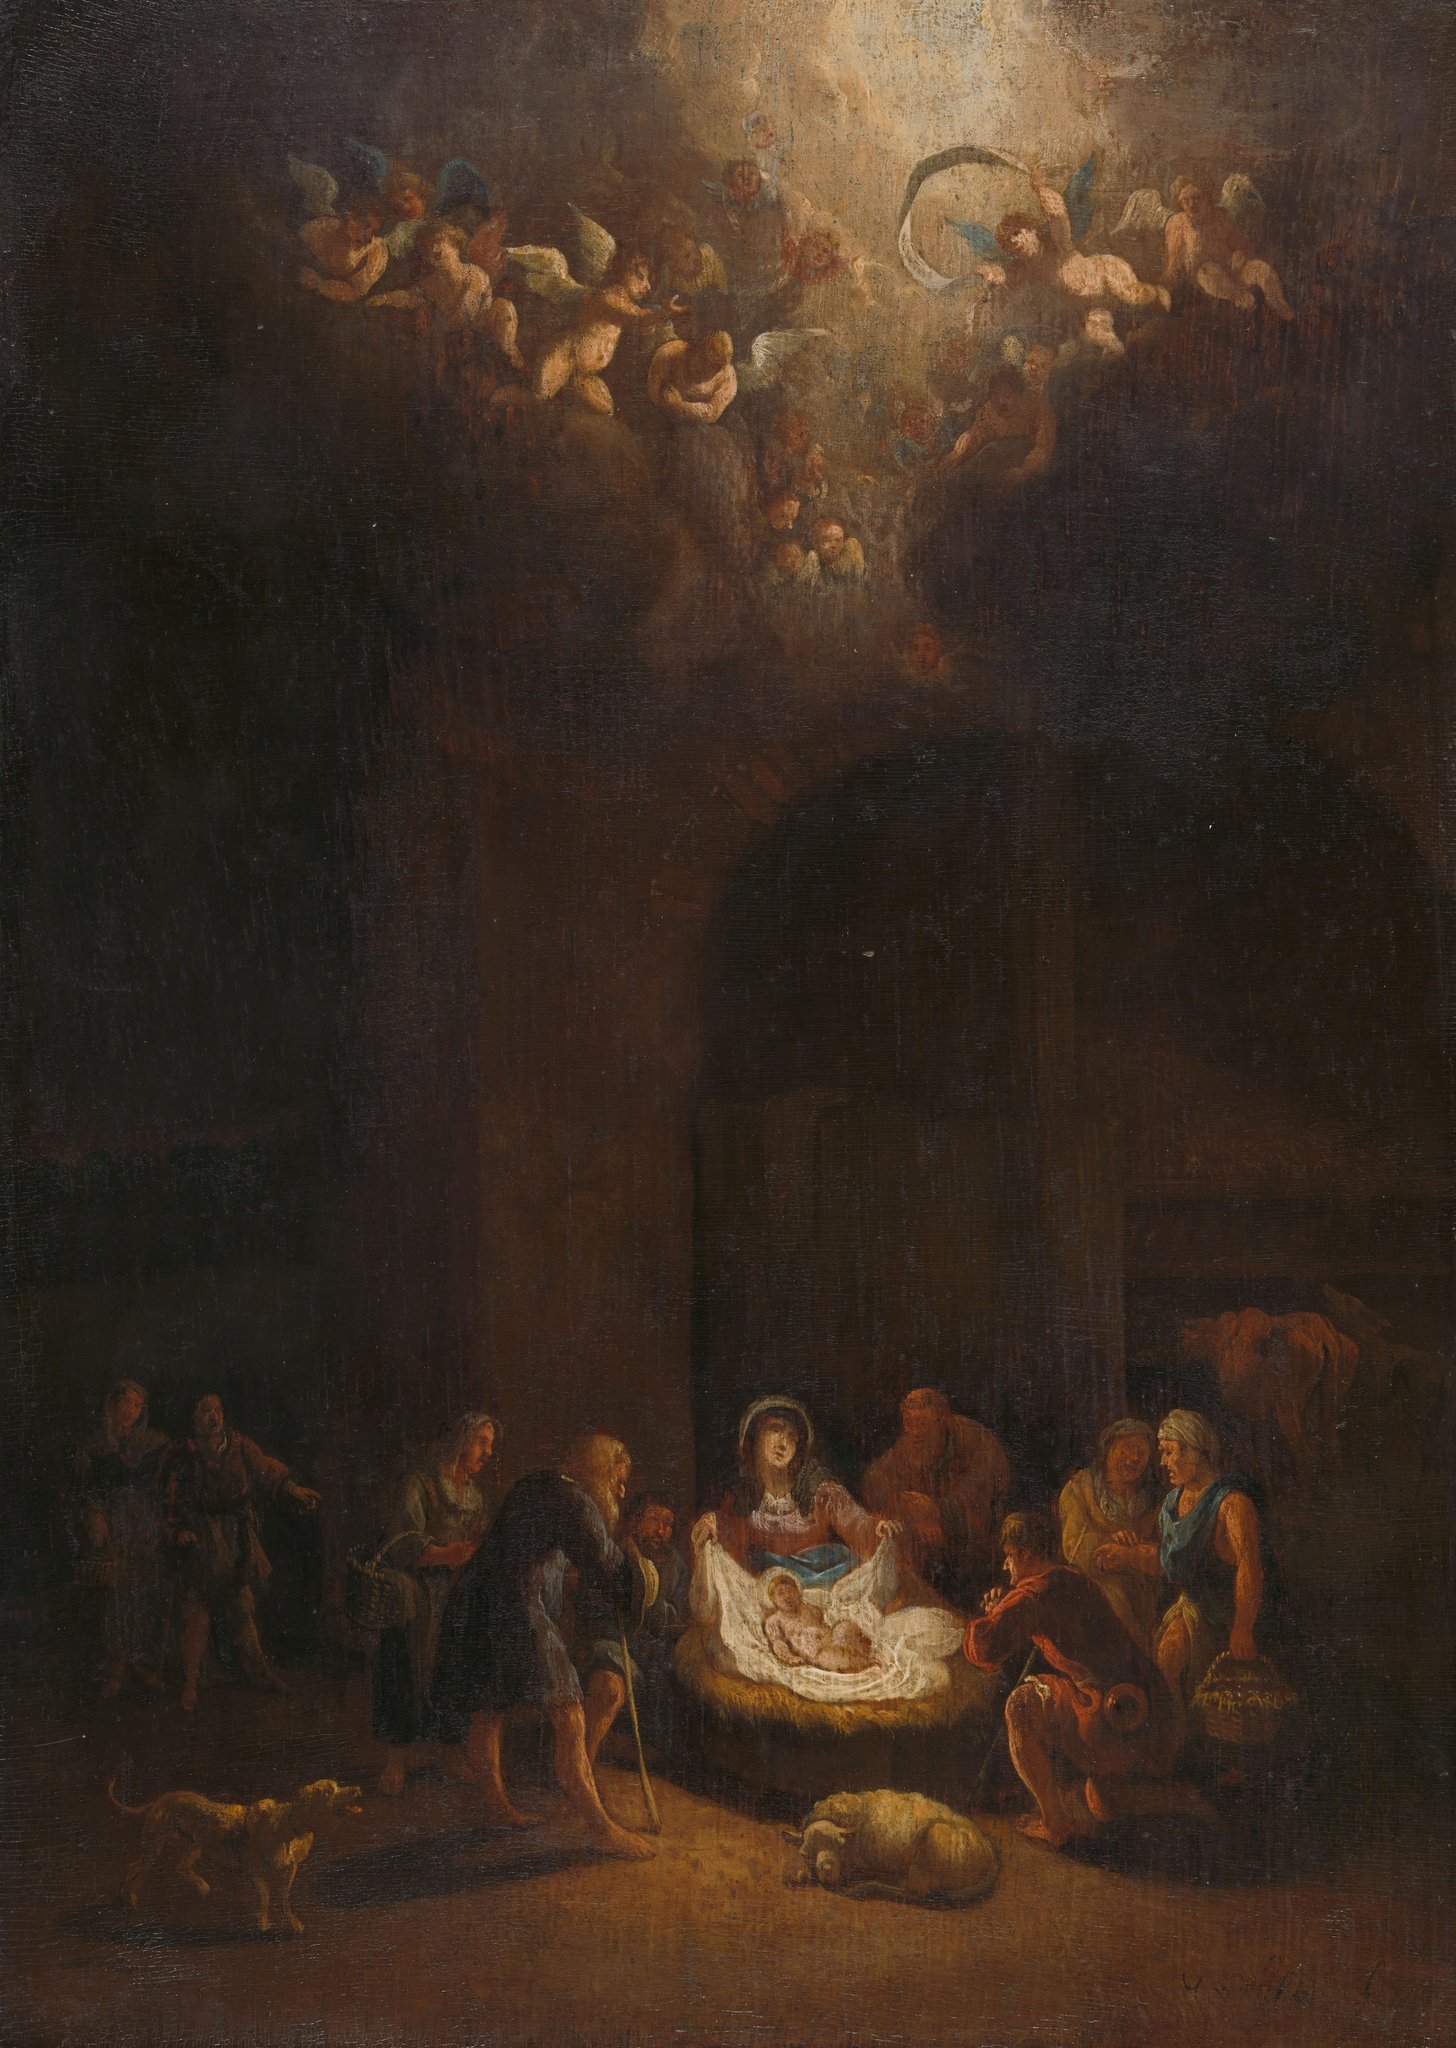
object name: painting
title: The Adoration of the Shepherds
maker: pieter bout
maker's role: draughtsman, print maker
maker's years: 1658-1719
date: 1680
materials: oil, panel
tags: adoration of the christ-child by the shepherds; mary and joseph present (+ angel(s) floating in the air)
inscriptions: signature, indecipherable text, bottom right, inscription, indistinct, top right, on the banderol held by the angel above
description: De aanbidding der herders. De herders hebben zich rond de verlichte kribbe verzameld. Maria tilt het laken op waarop het Christuskind ligt. Boven de stal zien engelen neer uit de hemel. Pendant van SK-A-2223.